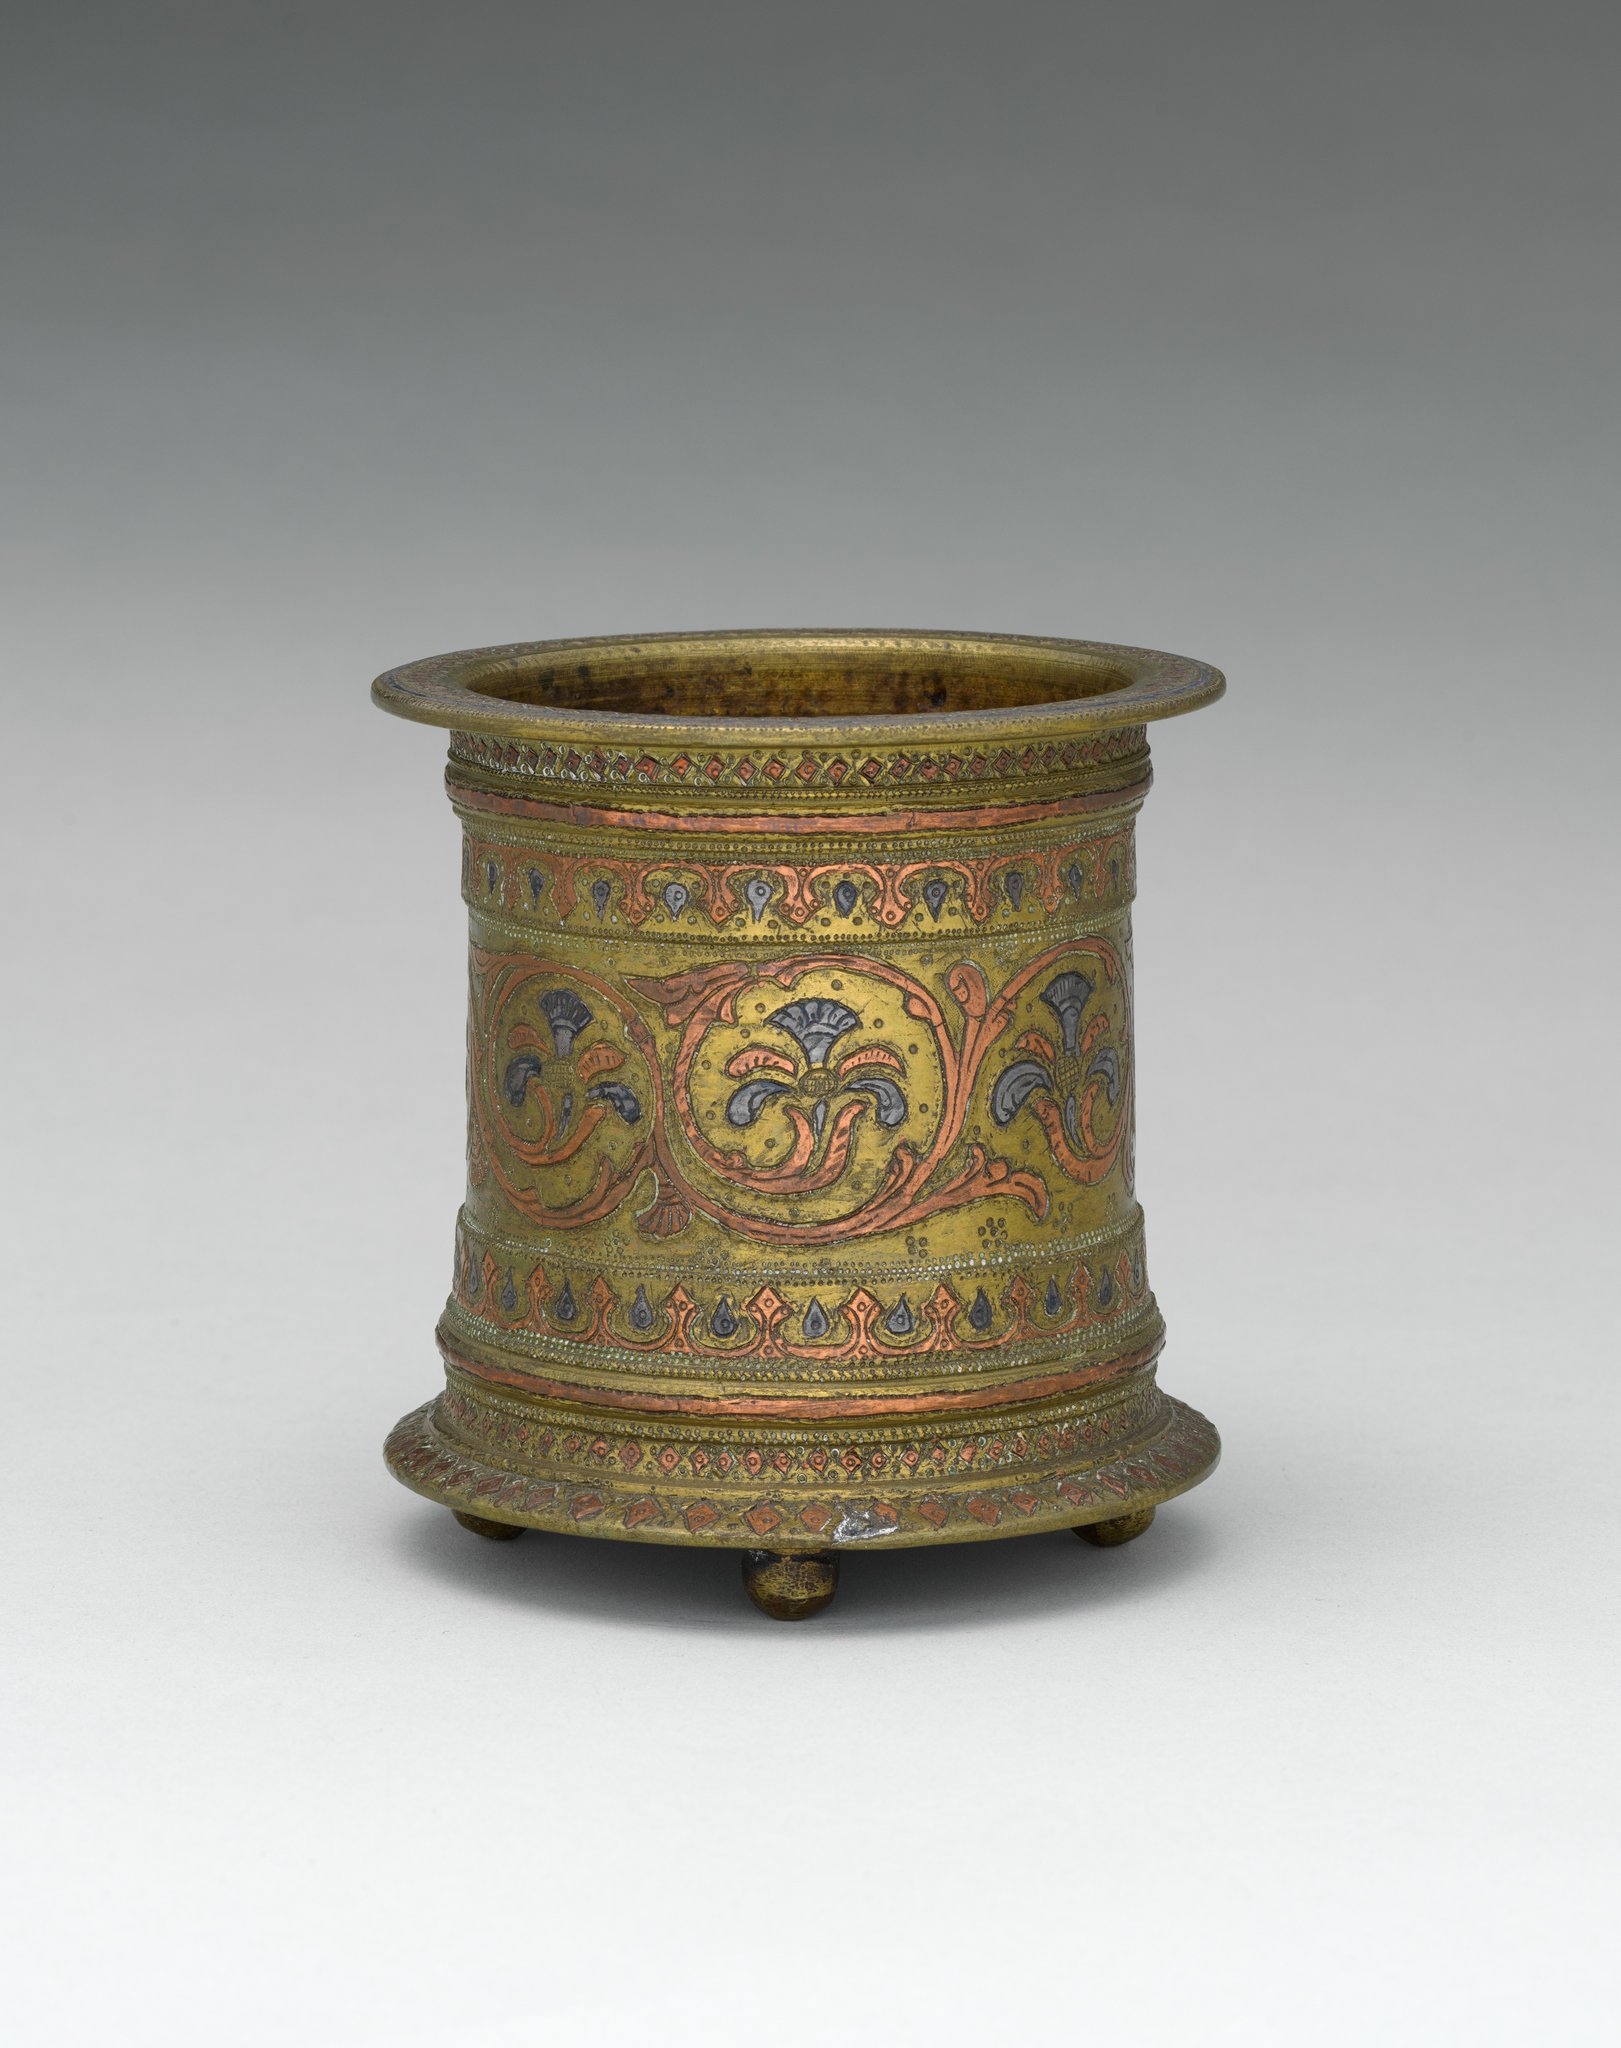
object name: vase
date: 1801-1900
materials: brass, copper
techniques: inlay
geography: india